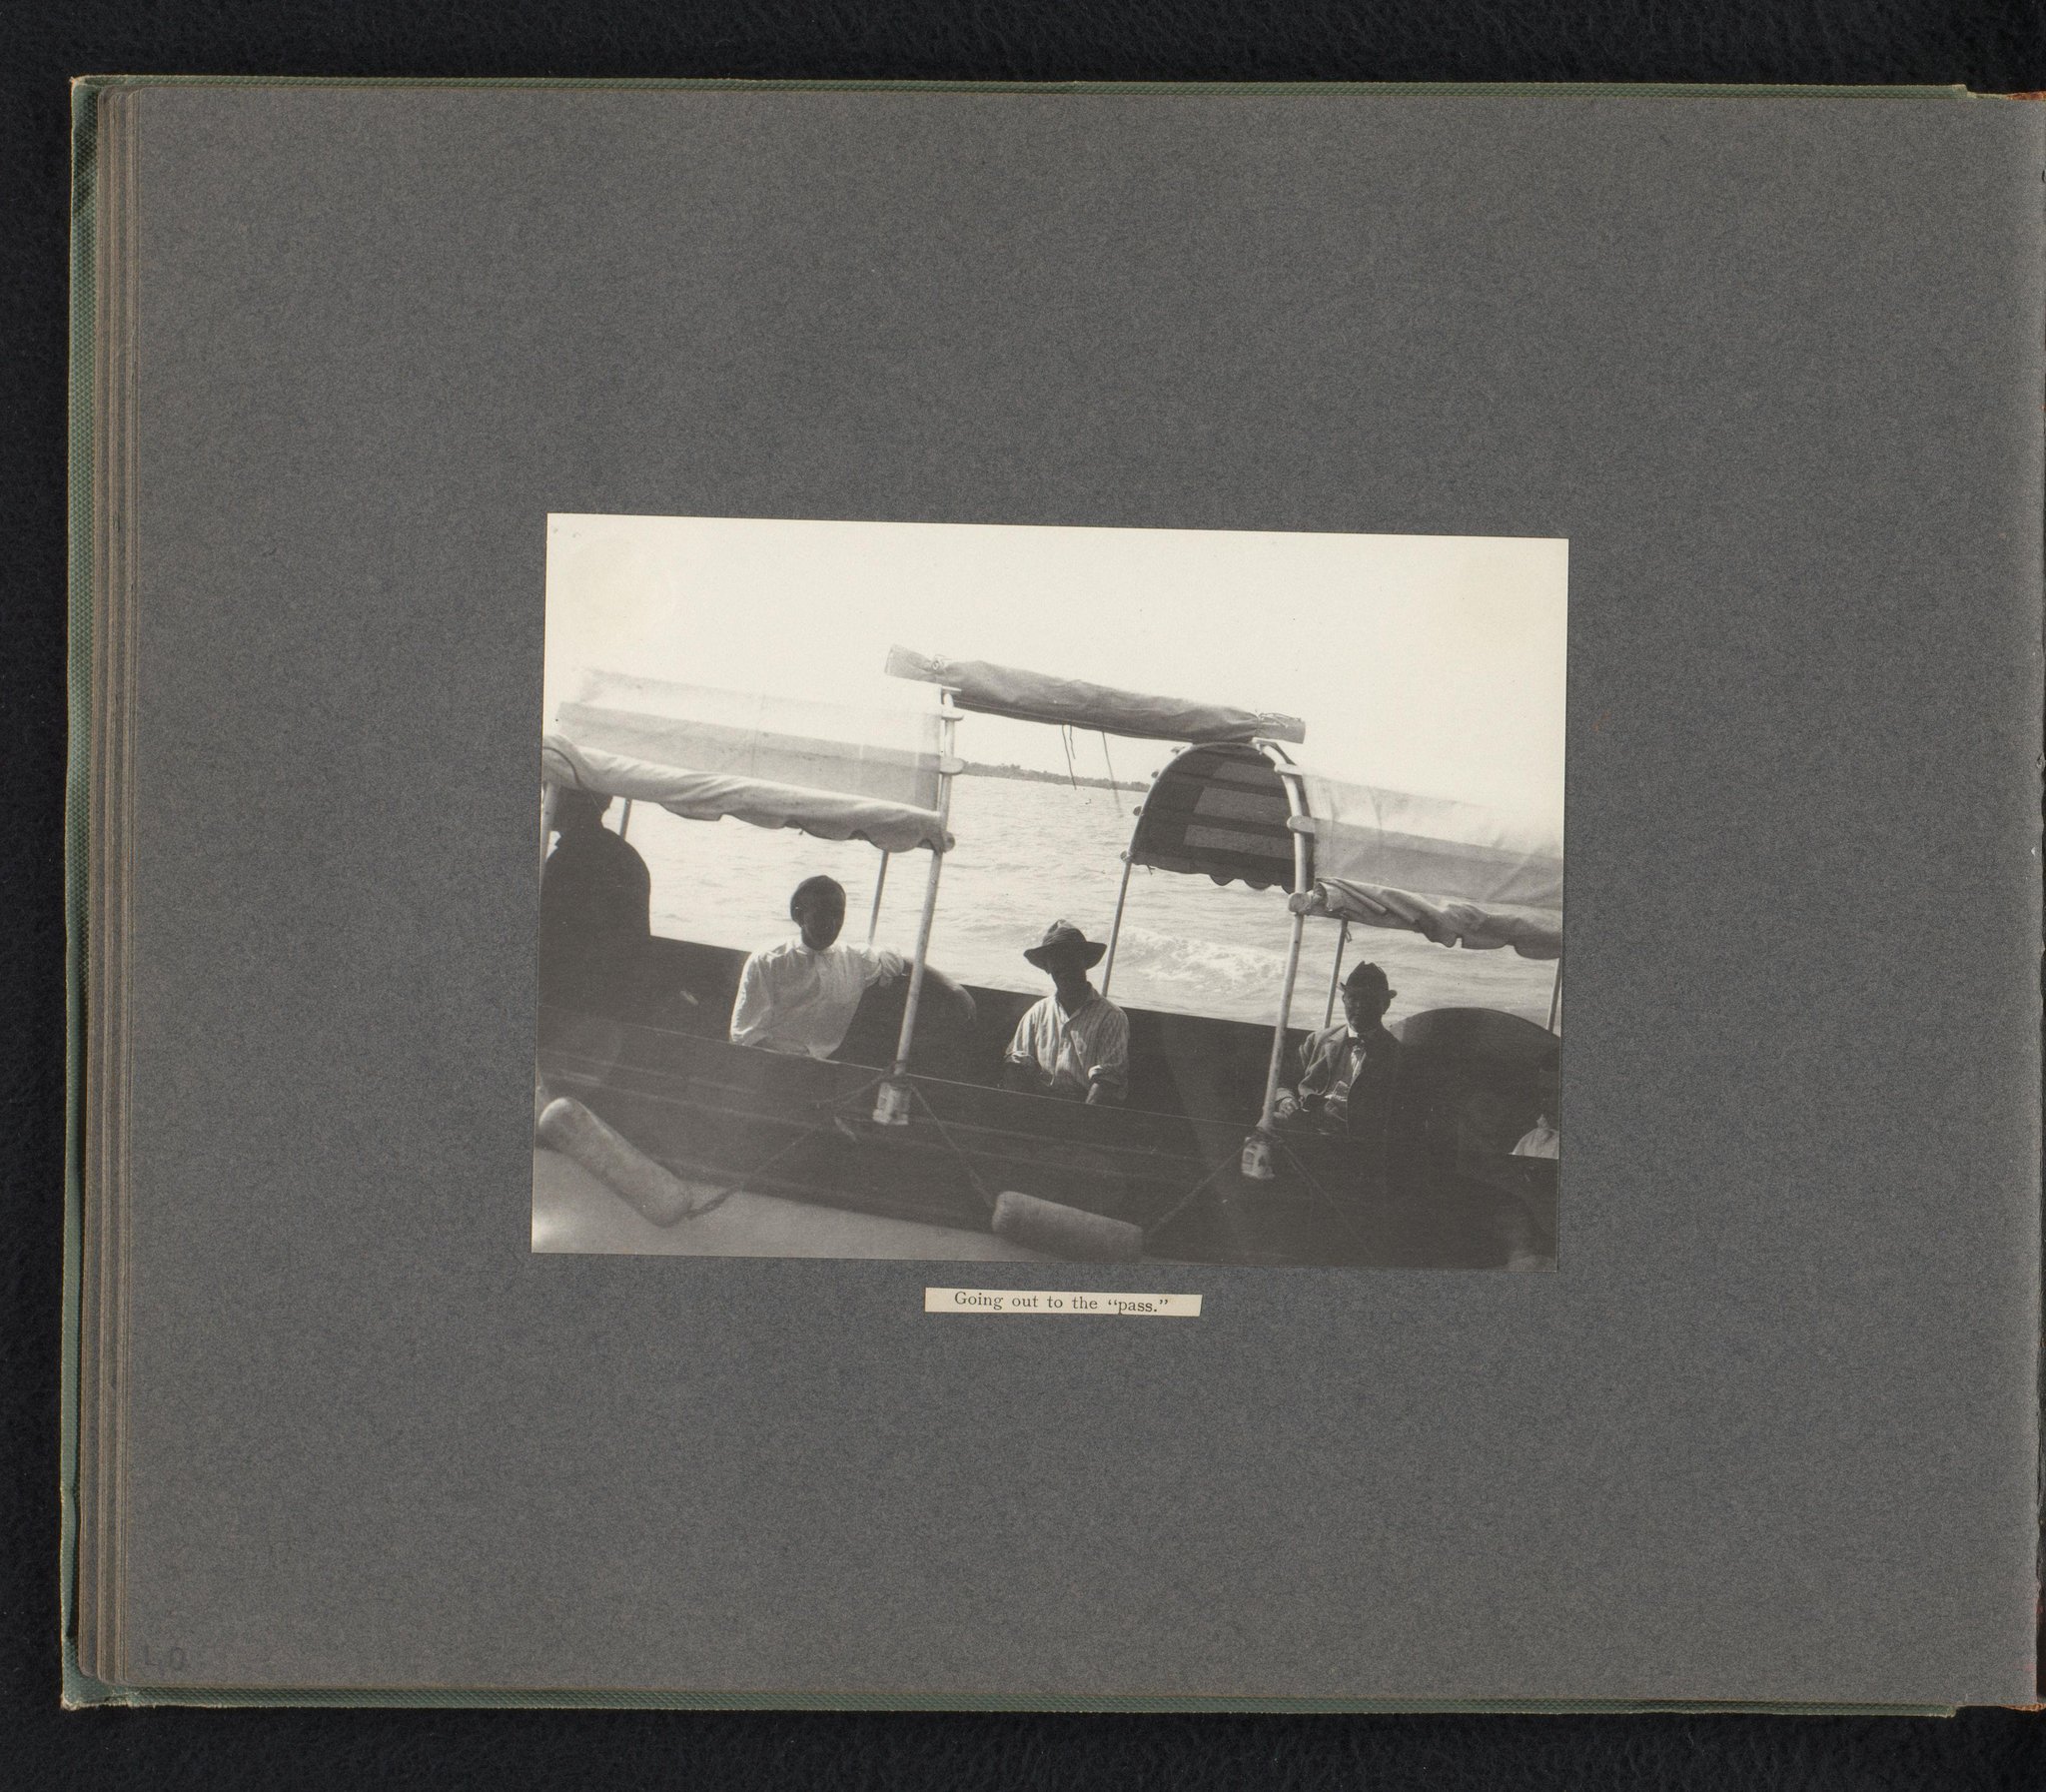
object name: photograph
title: Gezelschap in een overdekte sloep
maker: Anonymous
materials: paper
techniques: platinum process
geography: florida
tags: ships (in general)